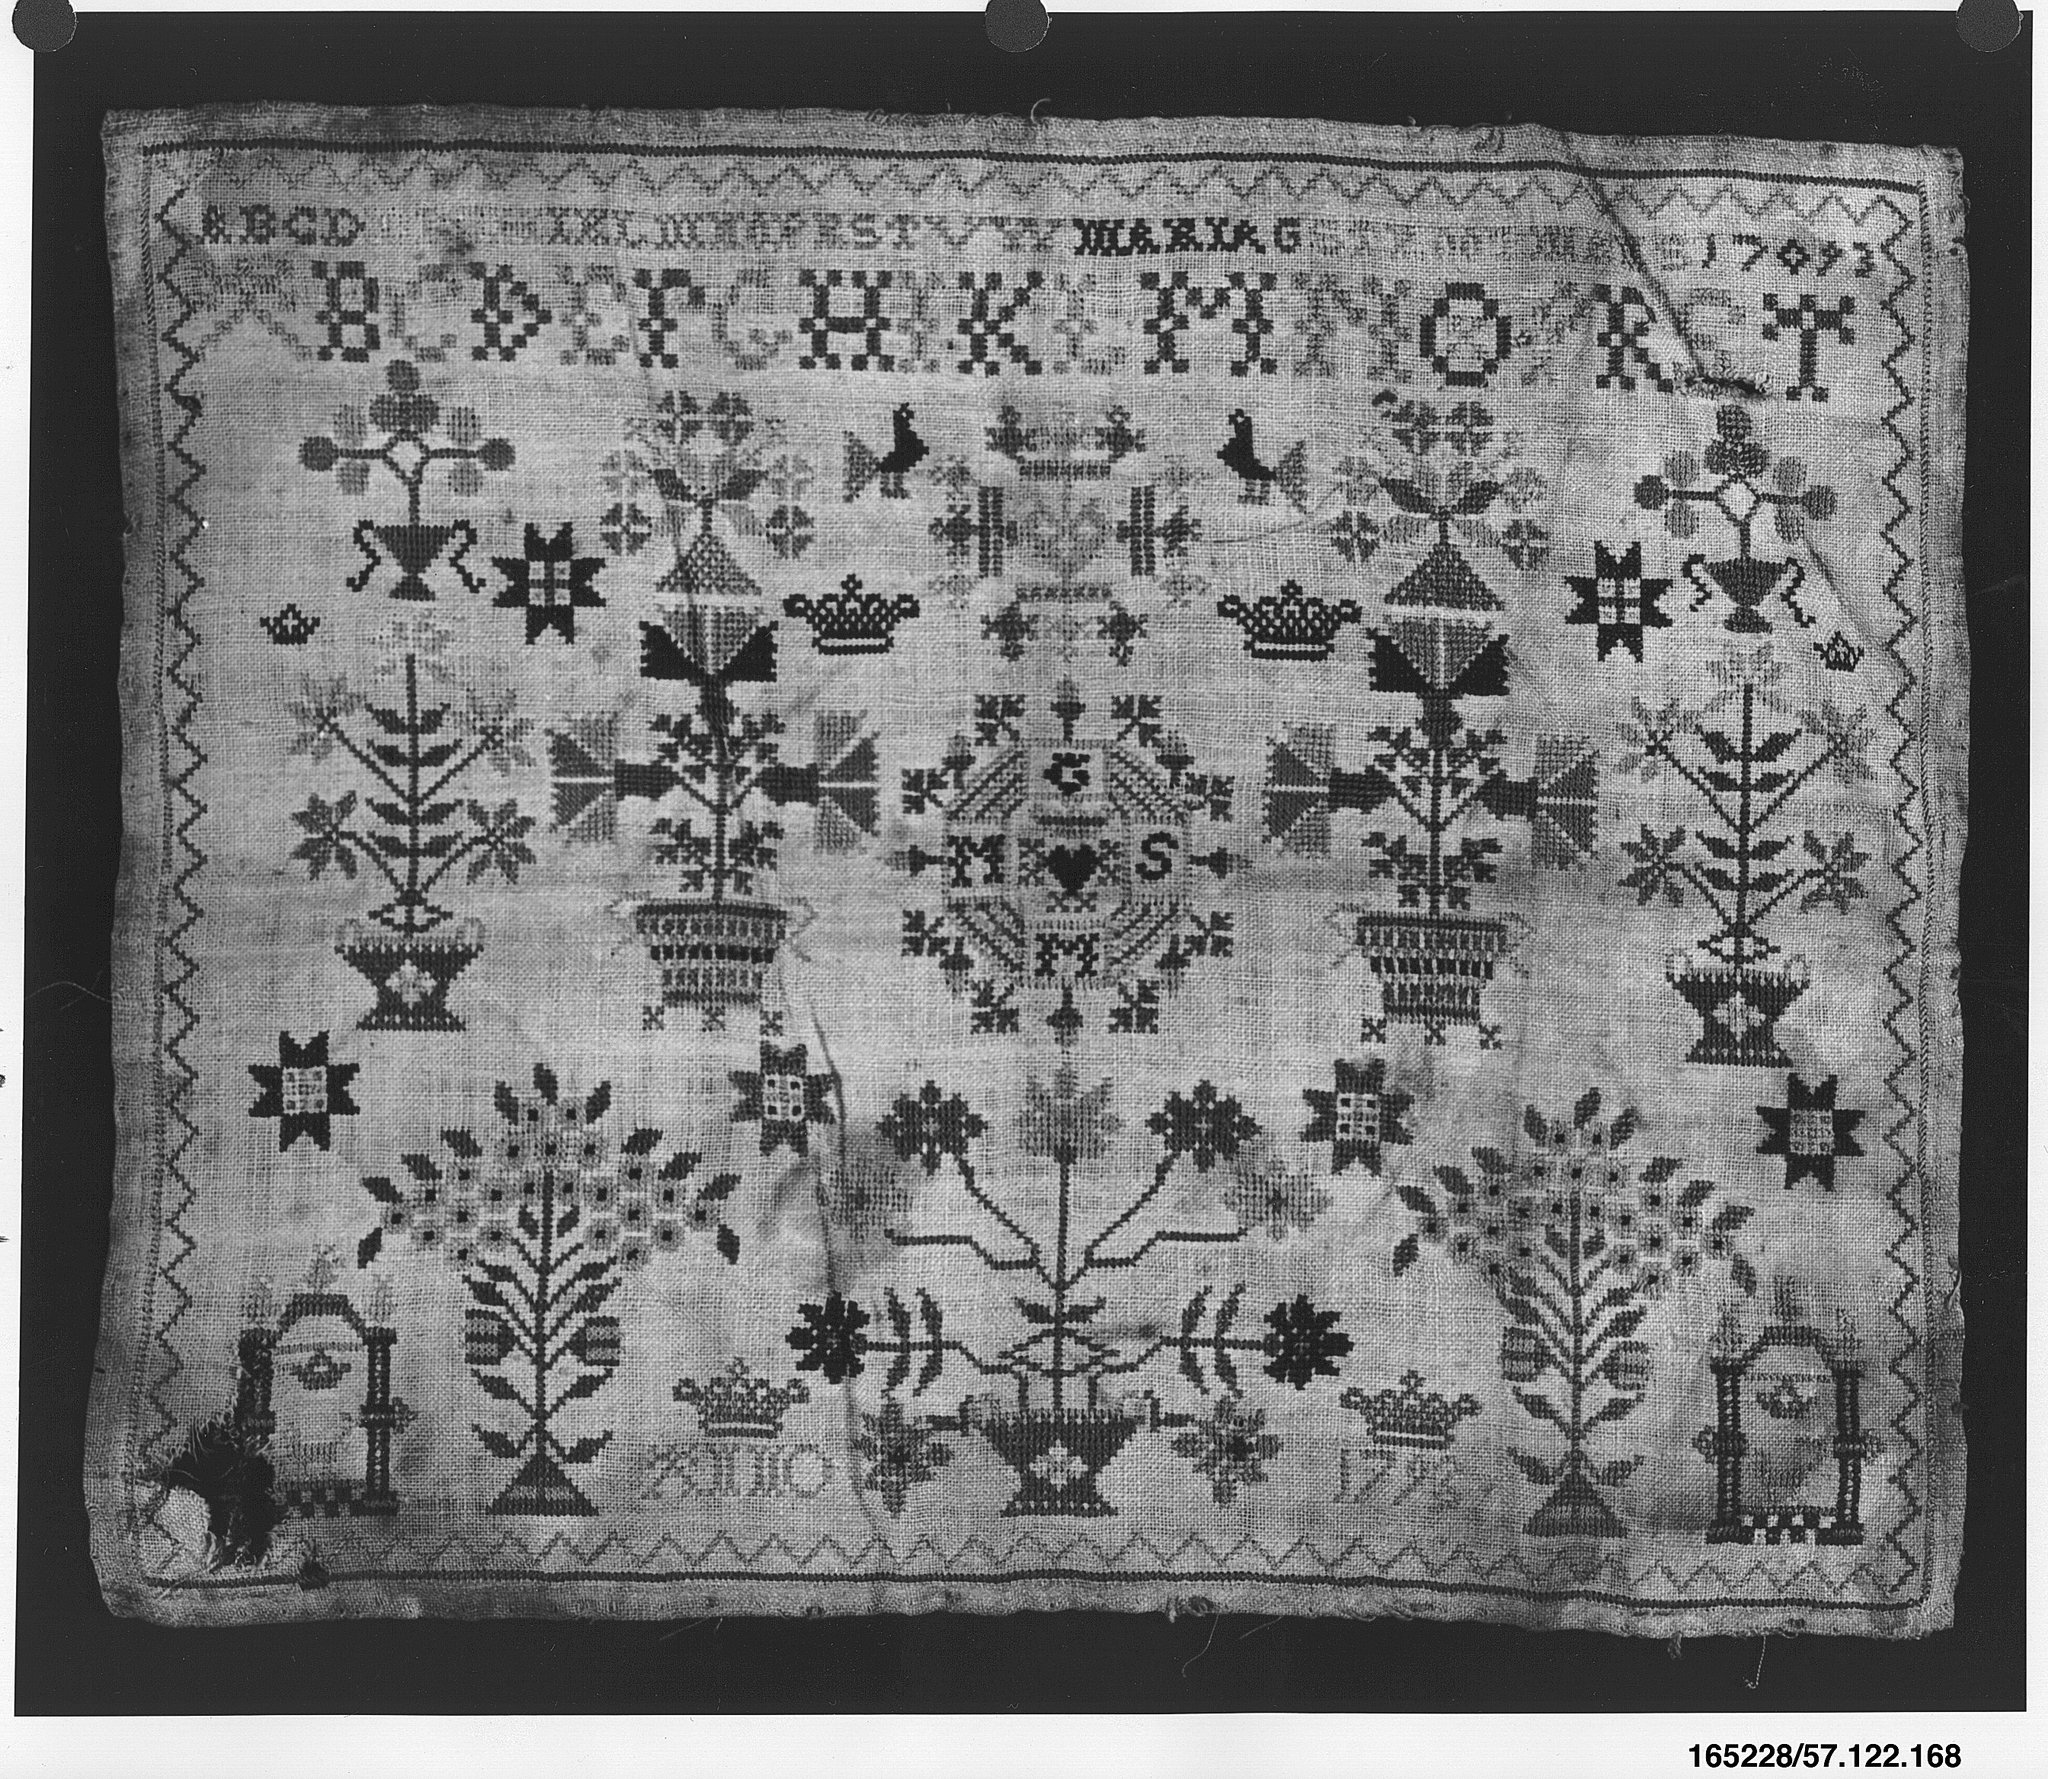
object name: sampler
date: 1793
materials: linen, silk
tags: flowers,insignia